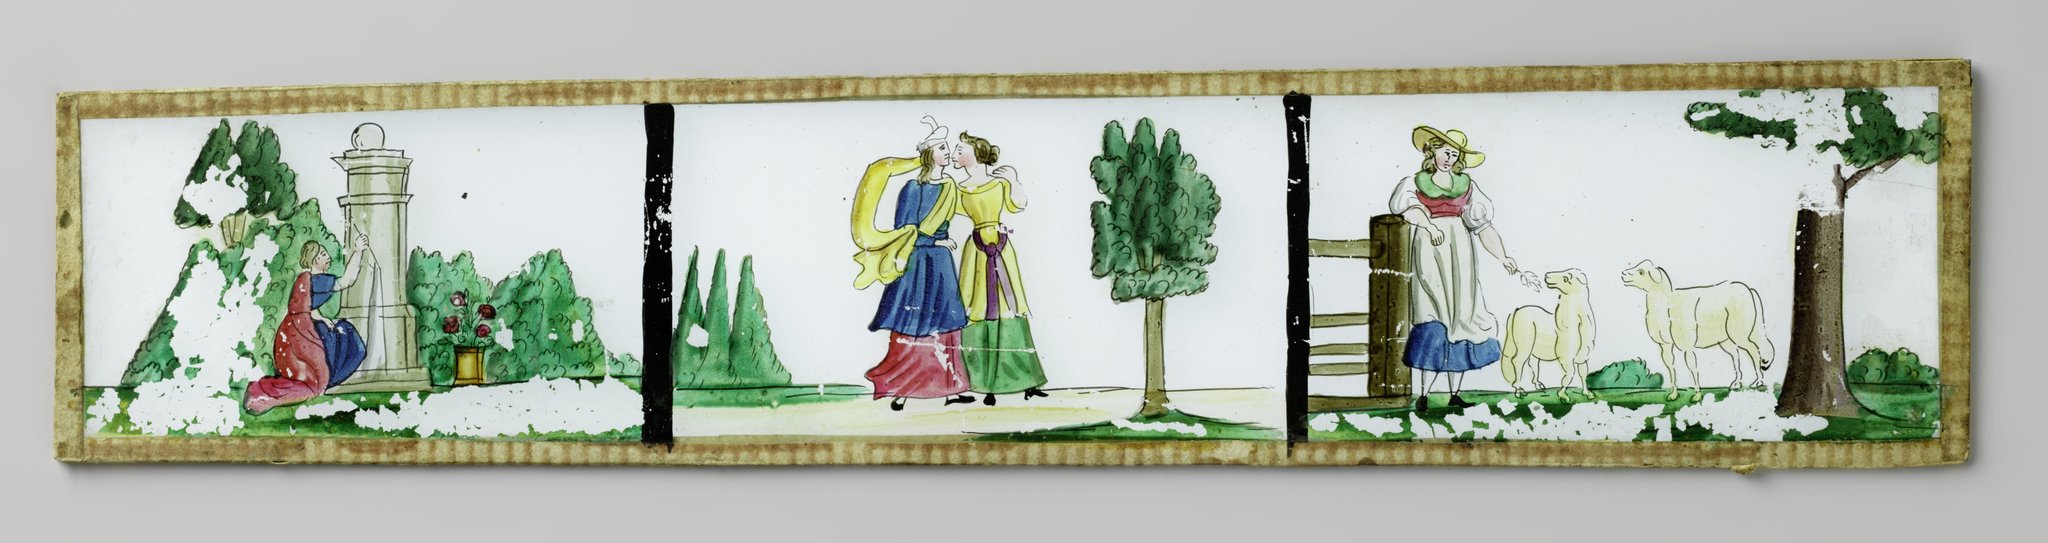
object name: lantern slide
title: Toverlantaarnplaatjes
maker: Anonymous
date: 1800-1900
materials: glass, paint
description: Een toverlantaarnplaat waarop een gehurkte vrouw, een elkaar beminnend paartje en een meisje met schapen staan afgebeeld.